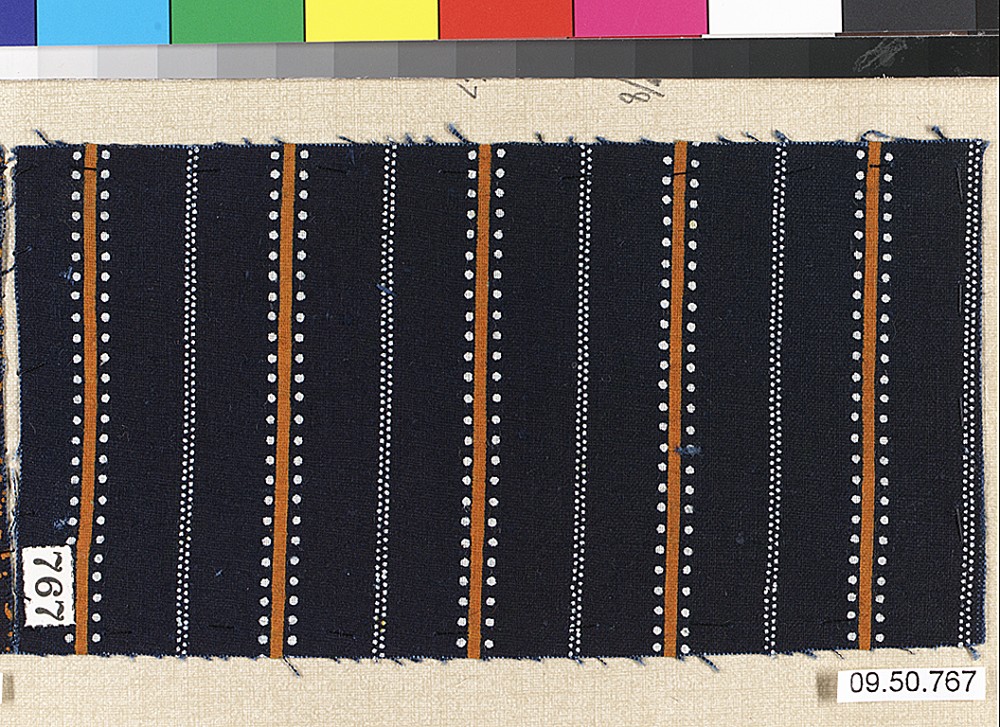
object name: piece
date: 1801-1900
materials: cotton